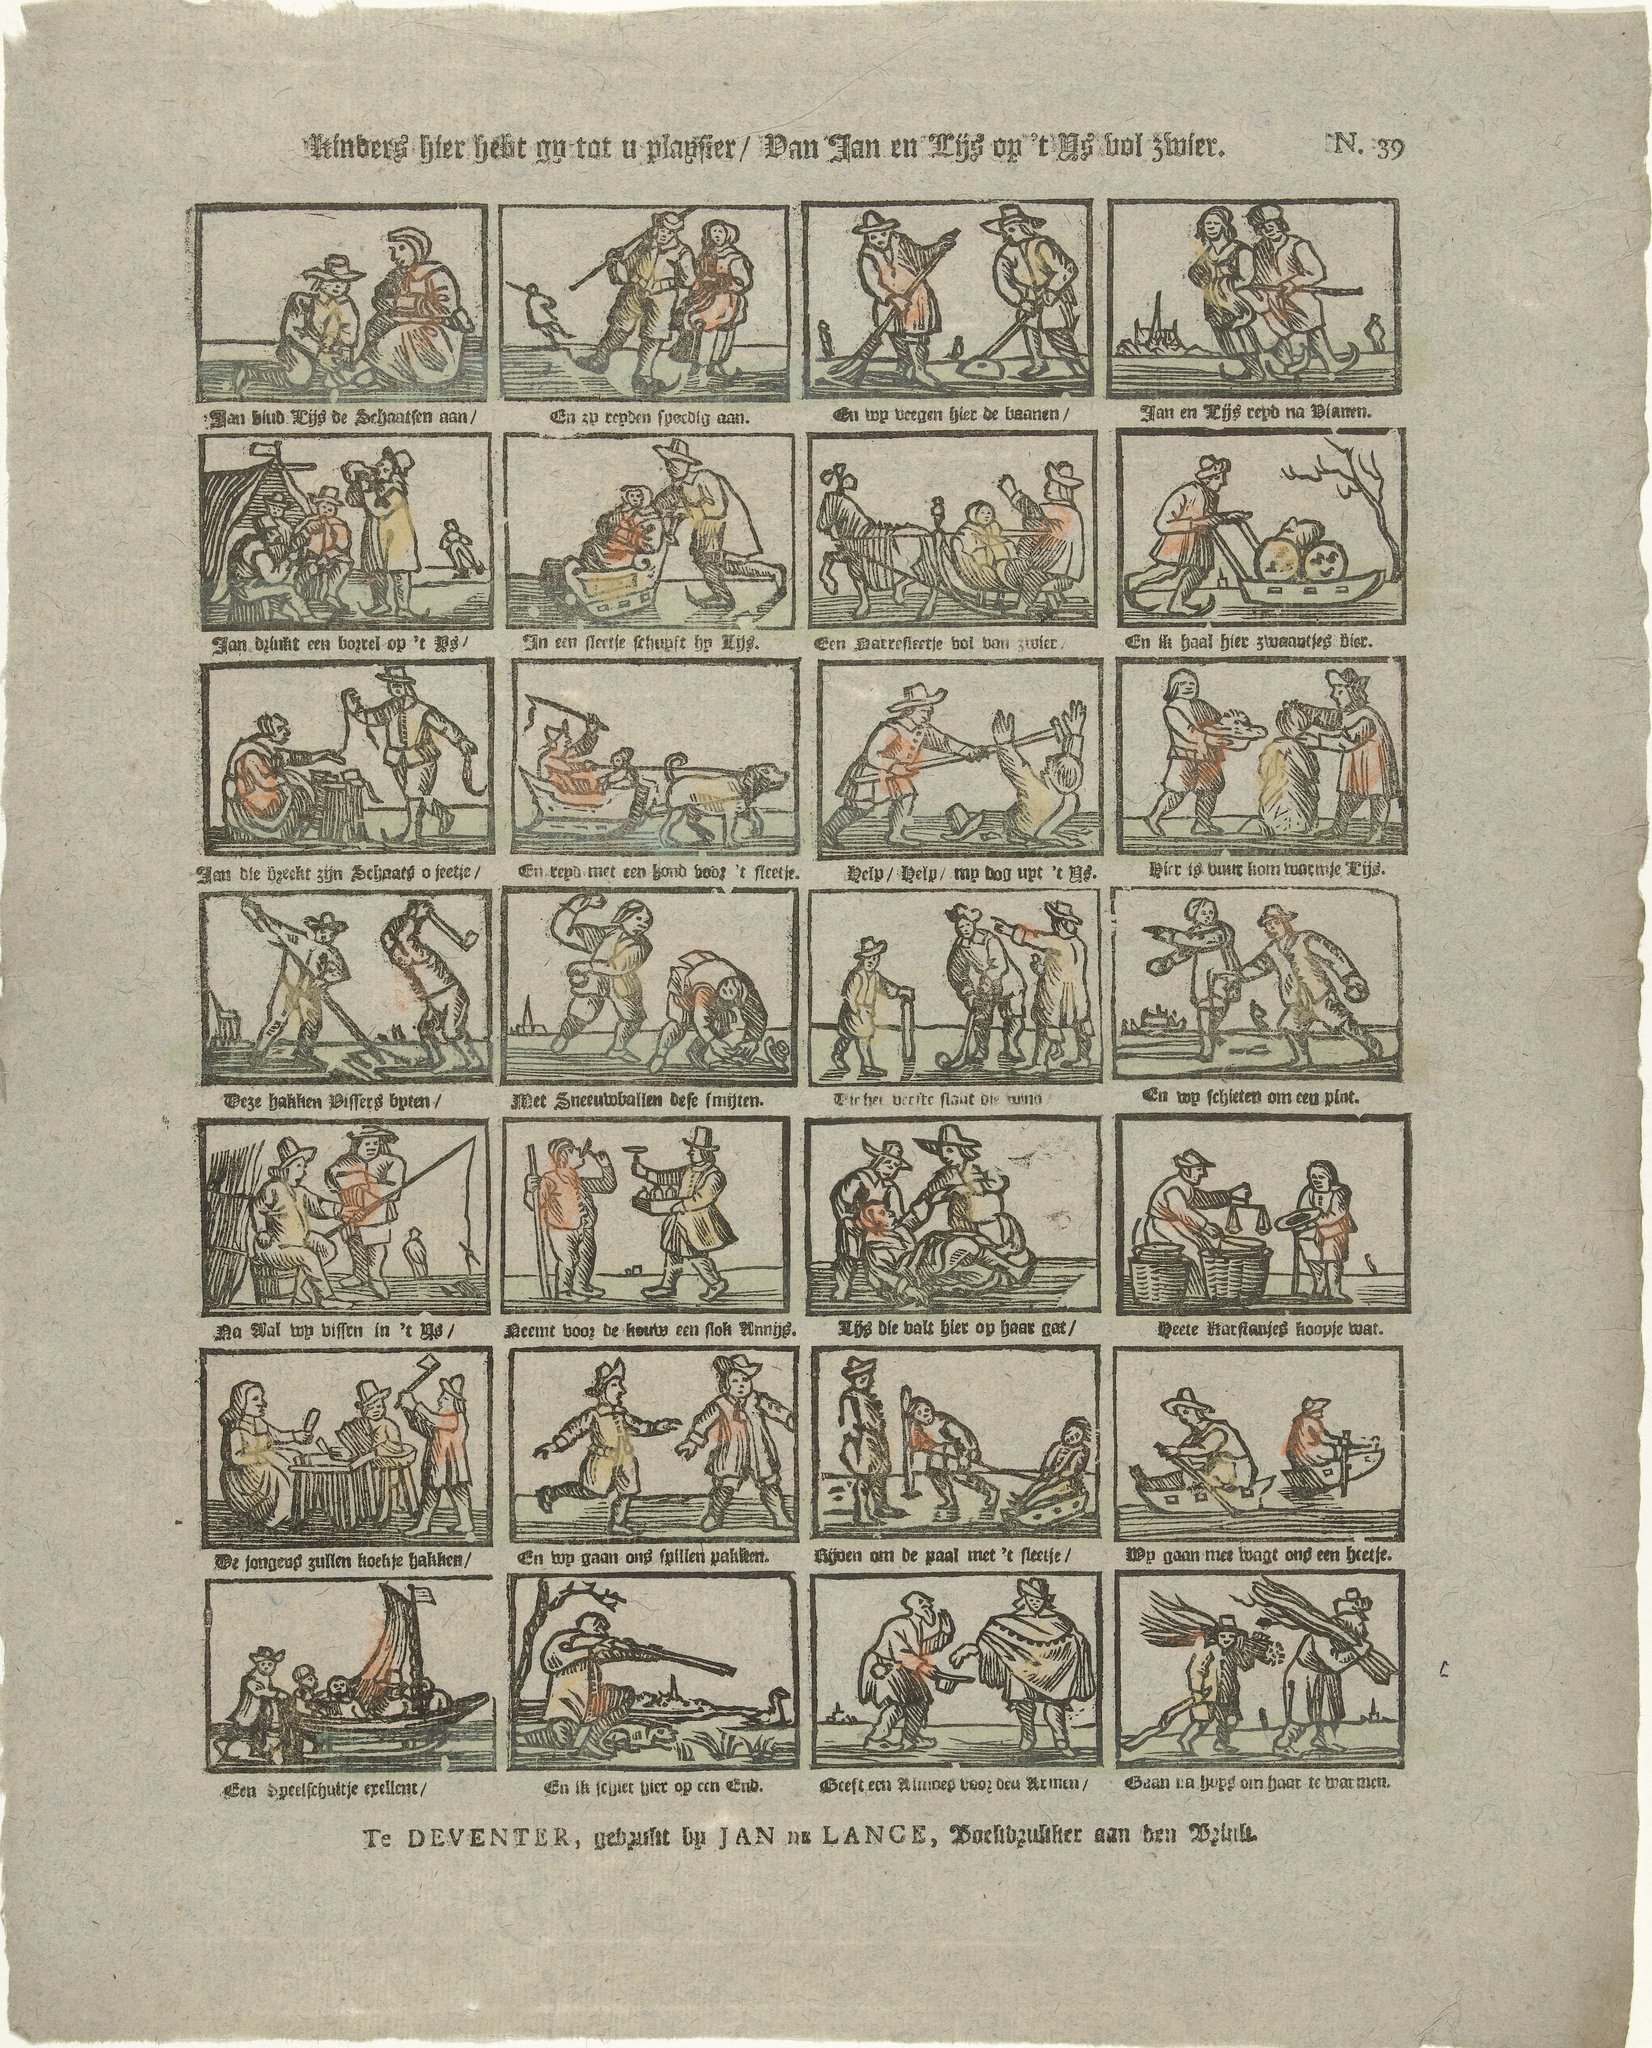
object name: popular print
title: Kinders hier hebt gy tot u playsier / Van Jan en Lijs op 't ys vol zwier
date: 1758-1787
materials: paper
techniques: colour, letterpress printing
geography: deventer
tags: winter sports, winter ~ human activities (the four seasons of the year), skates (winter sports), fishing (sports), sledge, sleigh (winter sports), playing with snow and ice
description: Blad met 28 voorstellingen van winterse taferelen, van onder andere mensen die schaatsen, sleeën en ijsvissen. Onder elke afbeelding een tweeregelig vers. Genummerd rechtsboven: N. 39.